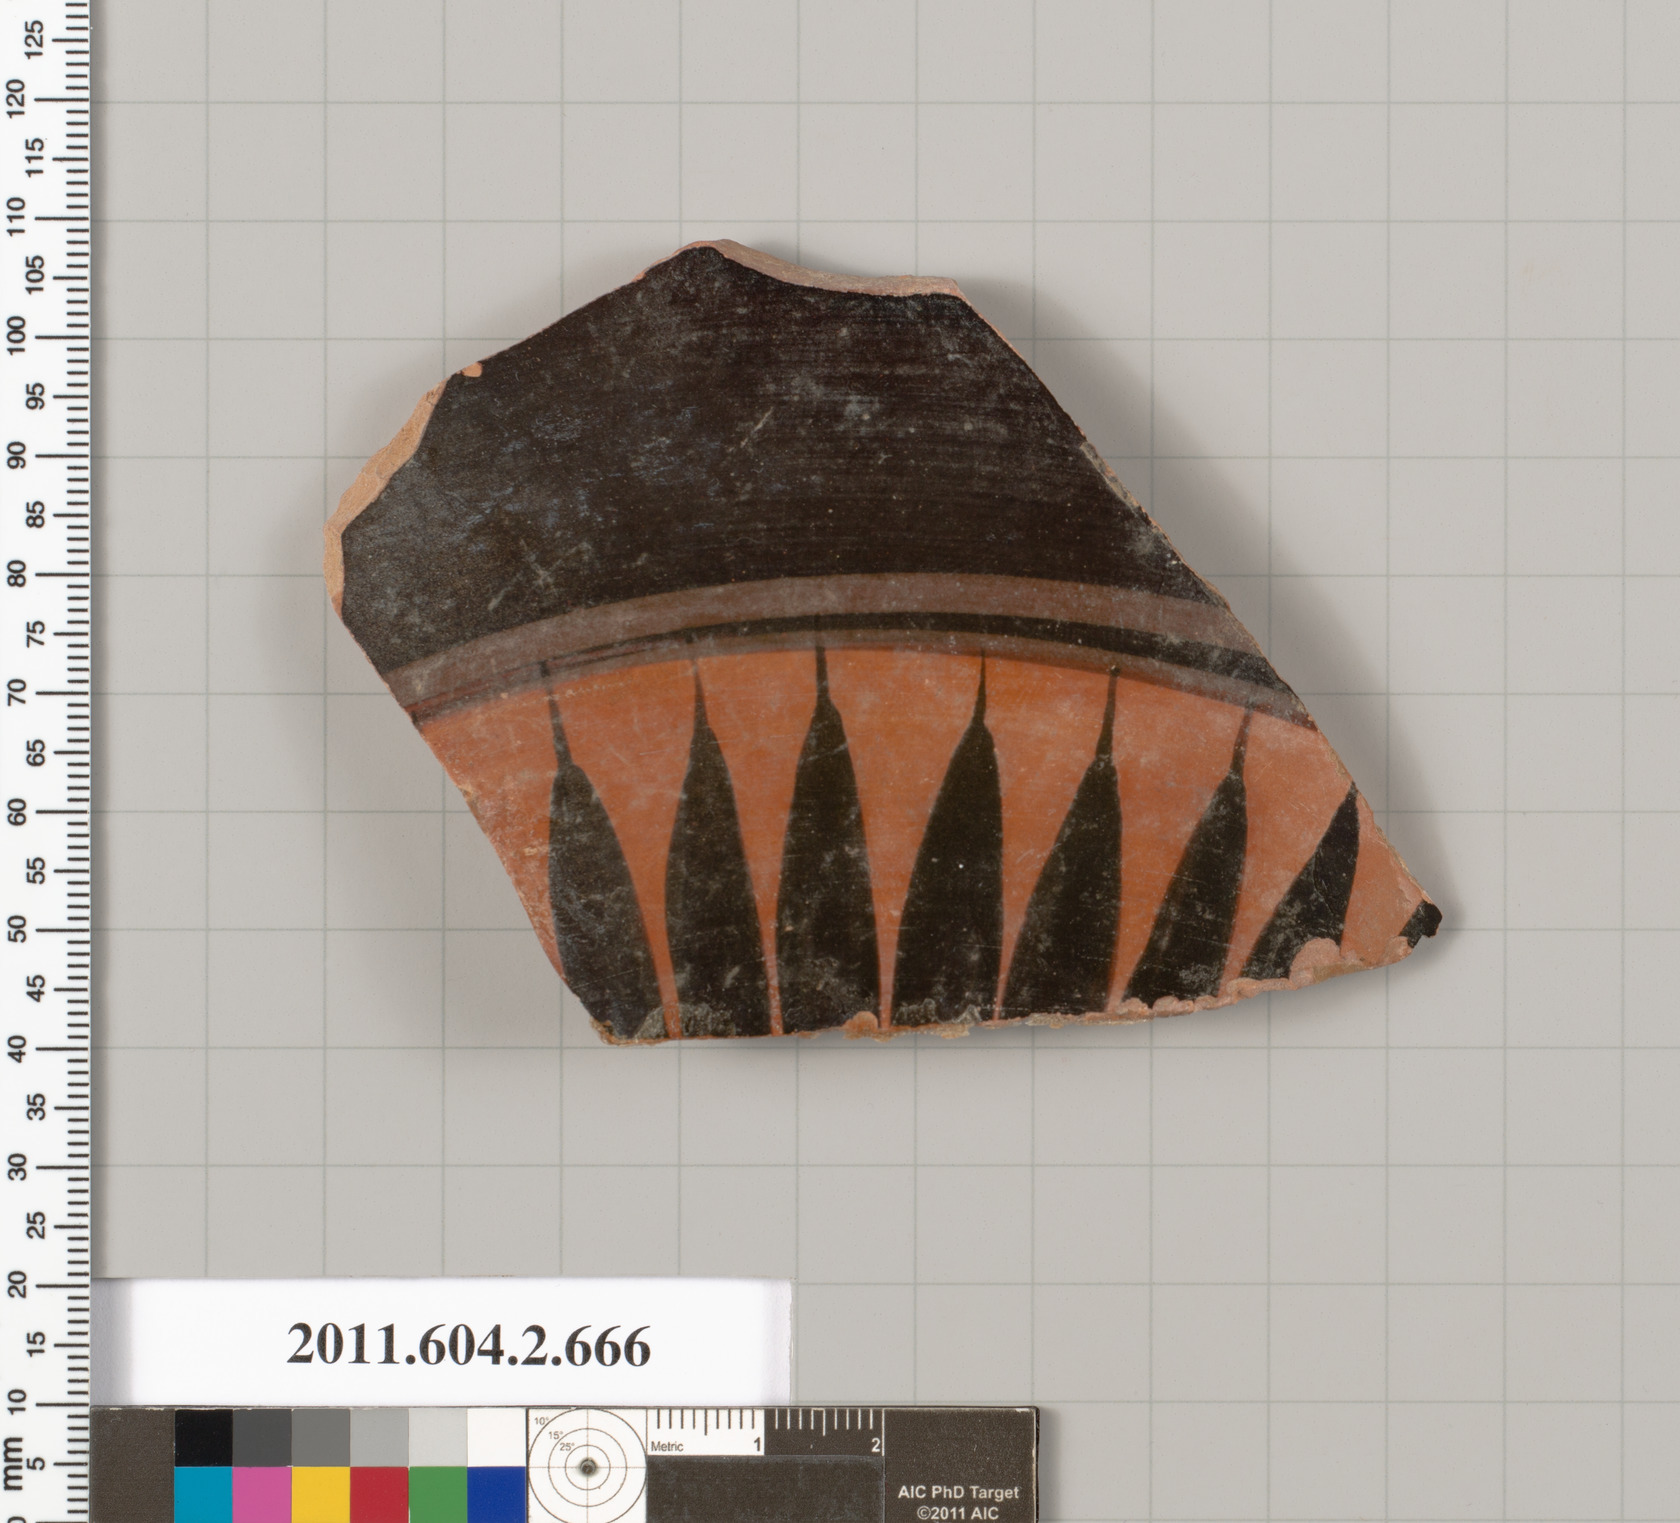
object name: column krater fragment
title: Terracotta fragment of a column-krater (bowl for mixing wine and water)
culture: greek, attic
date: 475-451 BCE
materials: terracotta